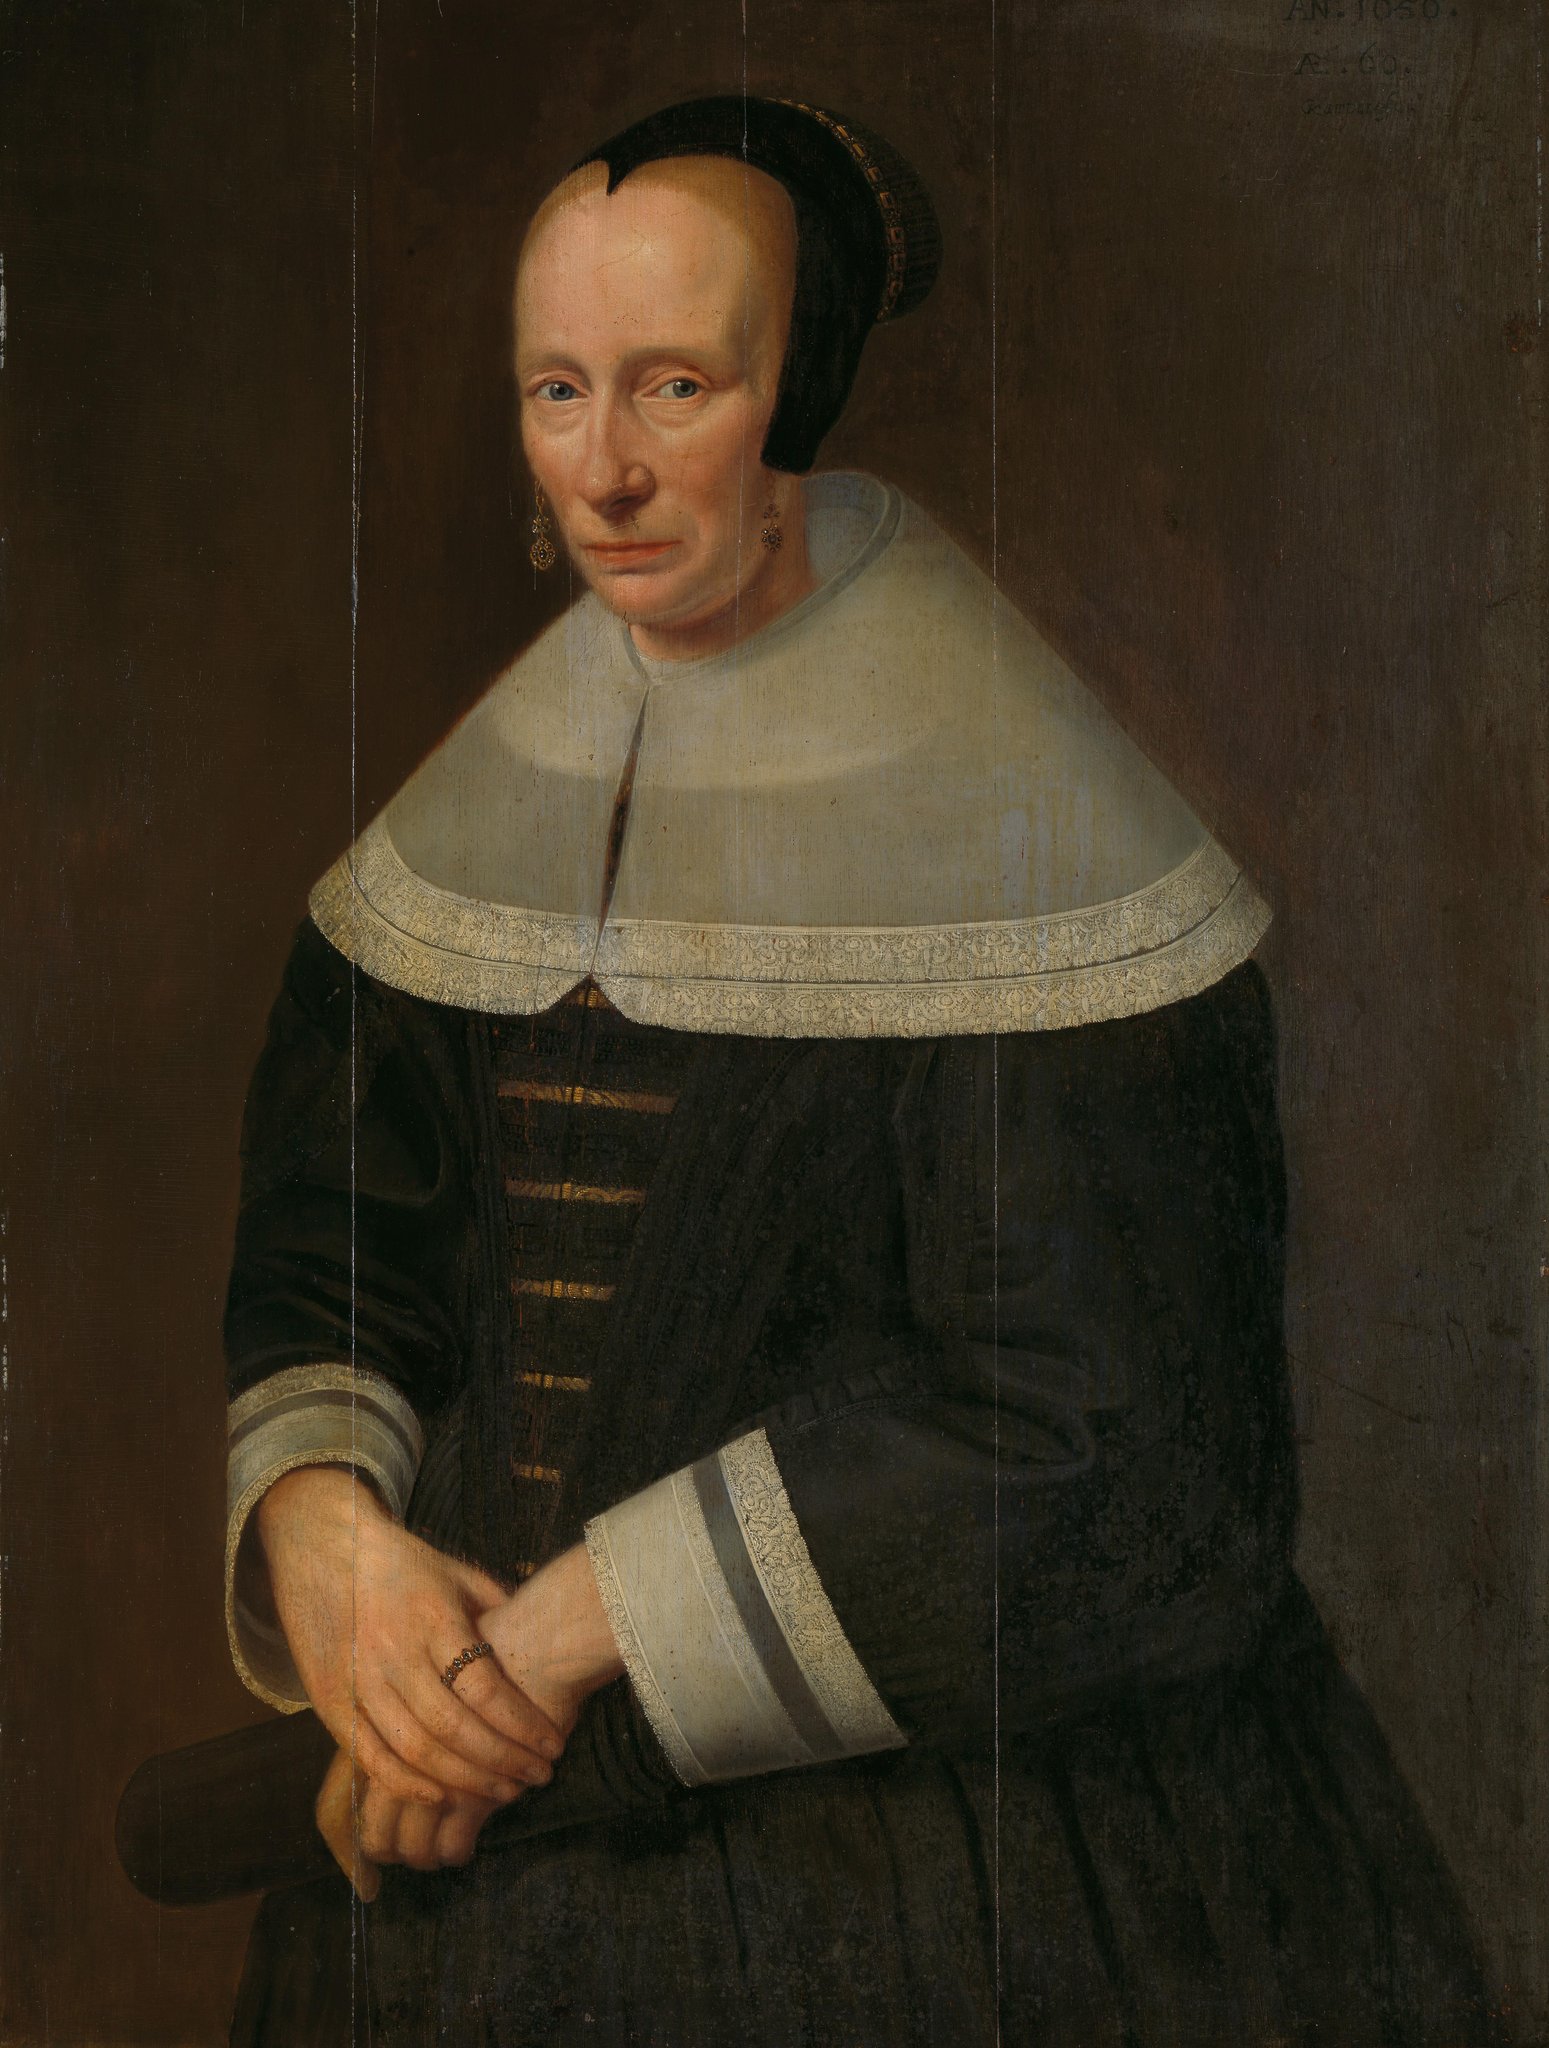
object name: painting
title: Portrait of a Woman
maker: godaert kamper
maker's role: painter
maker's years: 1613-1679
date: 1656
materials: oil, panel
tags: historical persons not known by name - bb - woman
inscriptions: inscription, top right: ‘Æ . 60 .’, signature, top right (G and K ligated): ‘GKamper. fe.’, date, top right: ‘AN . i656 .’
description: Portret van een zestigjarige vrouw. Staande, ten halven lijve, met de handen op de buik.